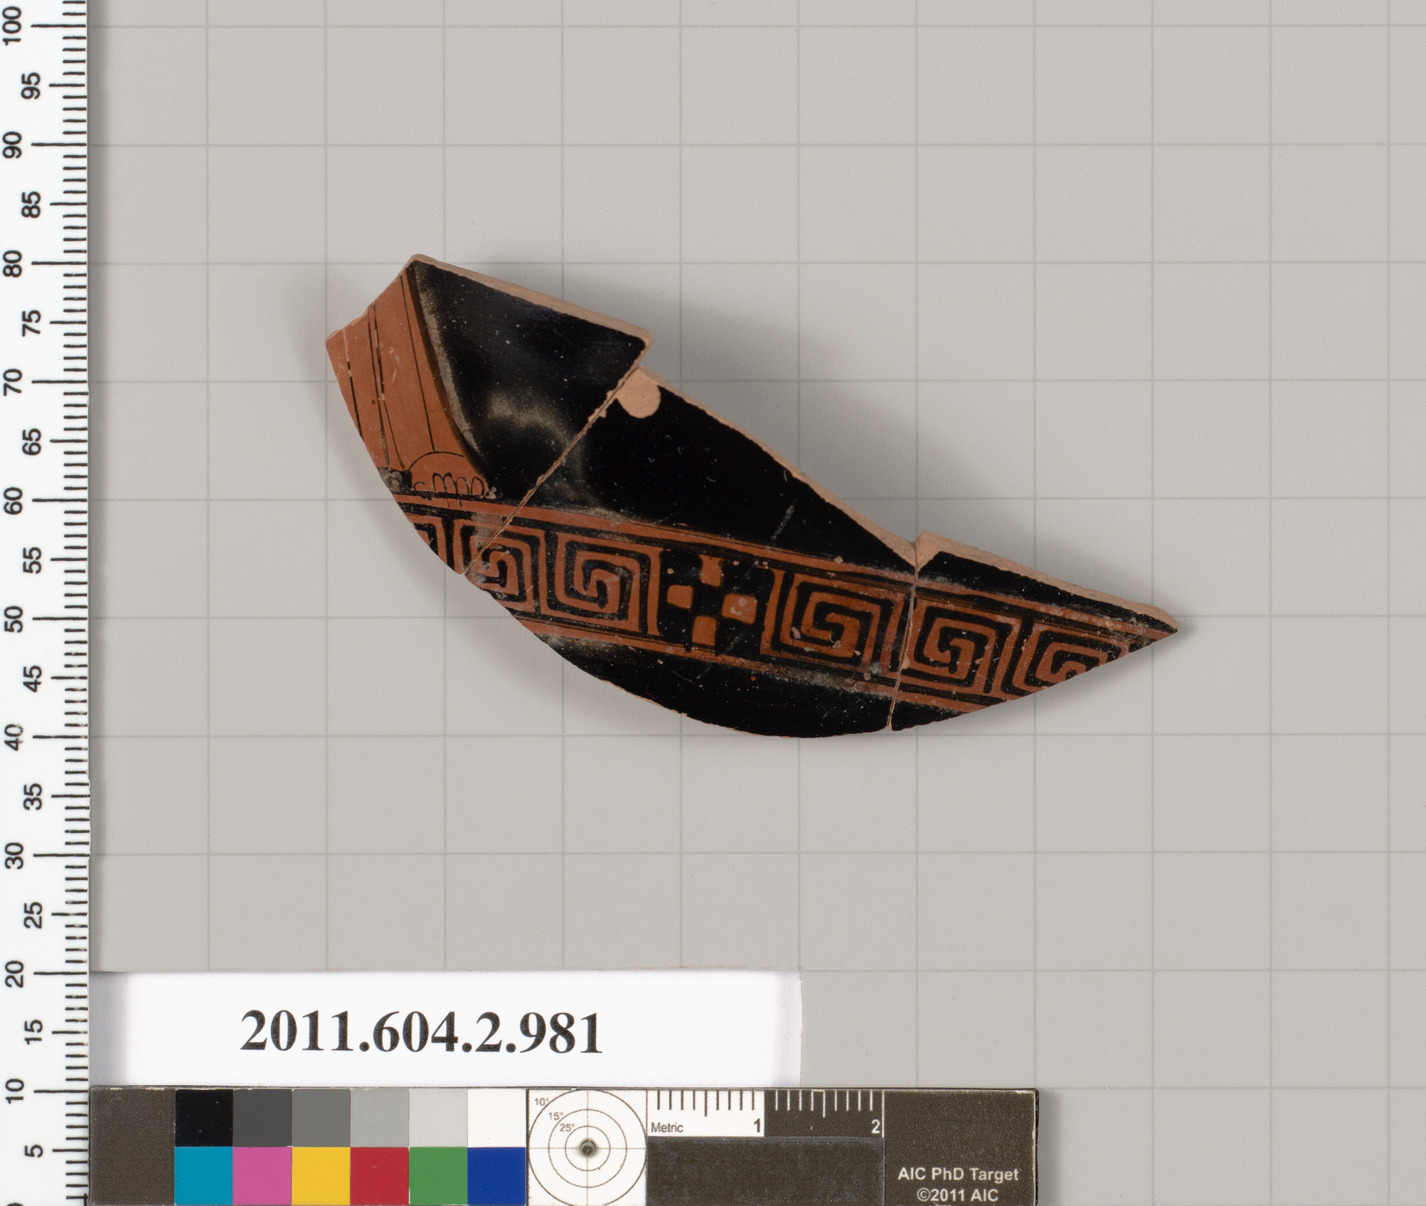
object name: chou fragment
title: Terracotta fragment of an oinochoe: chous (jug)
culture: greek, attic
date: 470-460 BCE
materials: terracotta